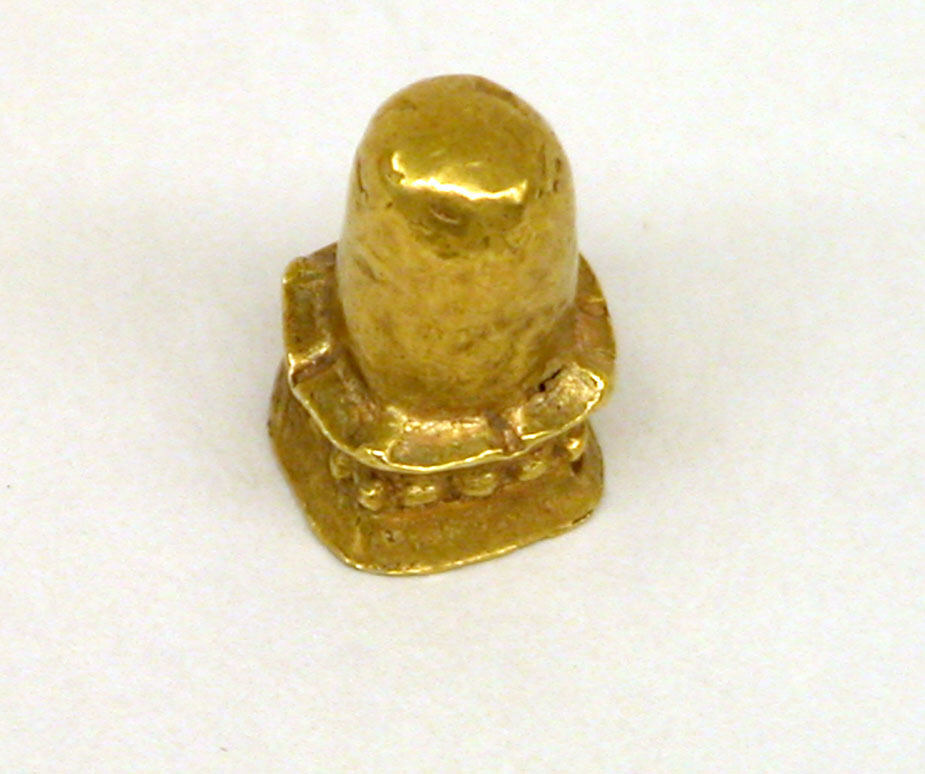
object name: linga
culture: indonesian, javanese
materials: gold